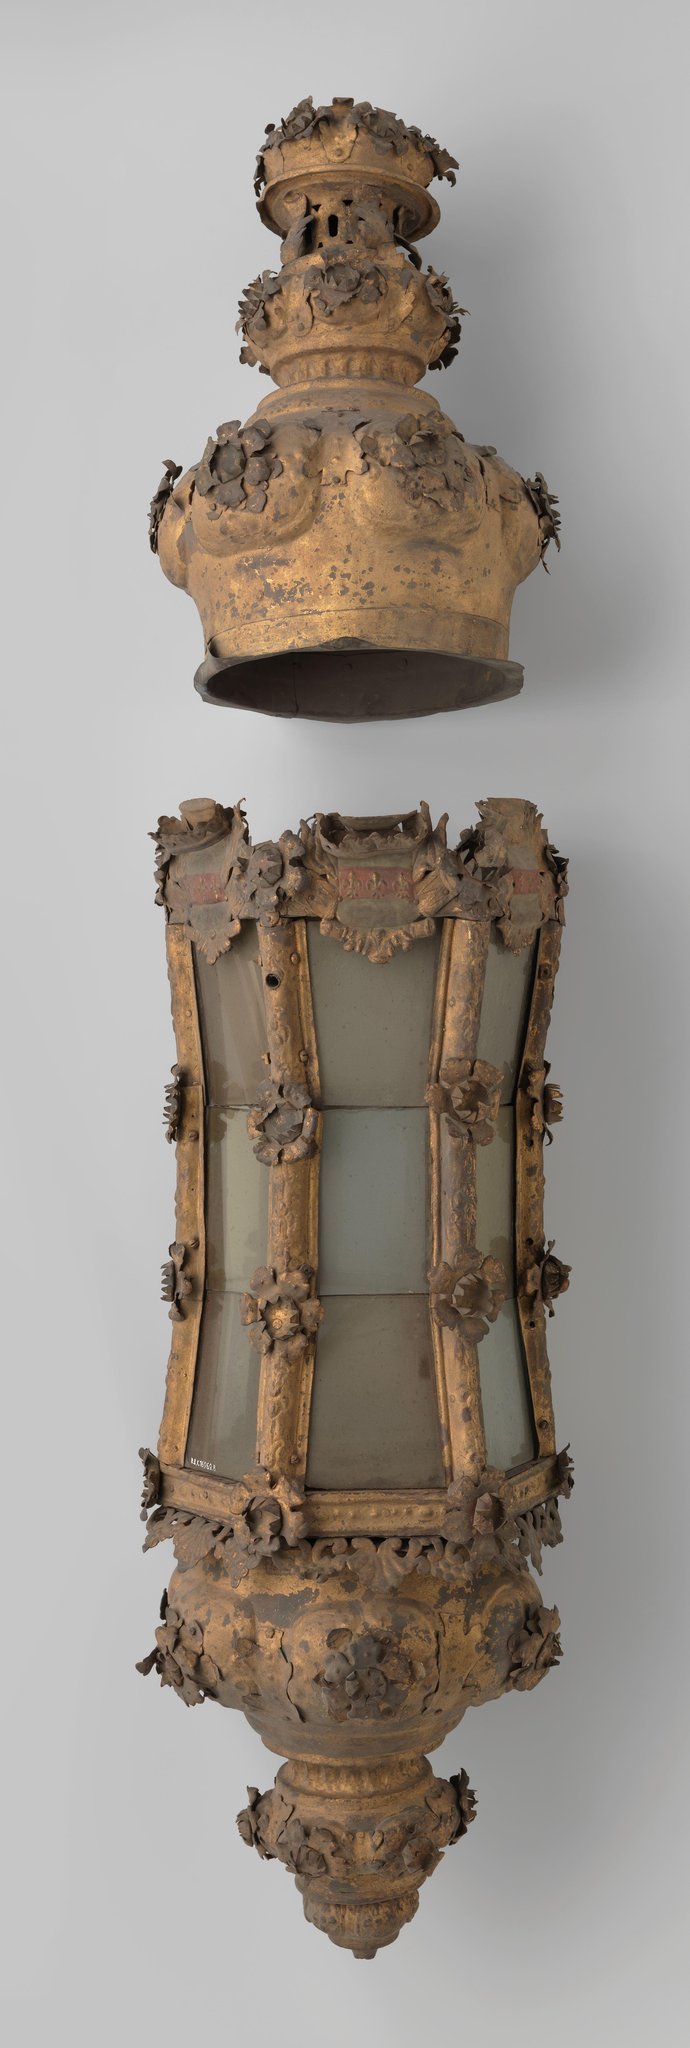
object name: lantern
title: Bodem van lantaarn met wapens boven de ruiten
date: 1700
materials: iron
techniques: gilding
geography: venice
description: Bodem van de lantaarn, omgekeerd gelijk aan het dak (zie BK-16969-B-1), echter zonder de laatste geleding. De lamp wordt versierd met rozetten. Afkomstig uit de verzameling Dr. F. Mannheimer.